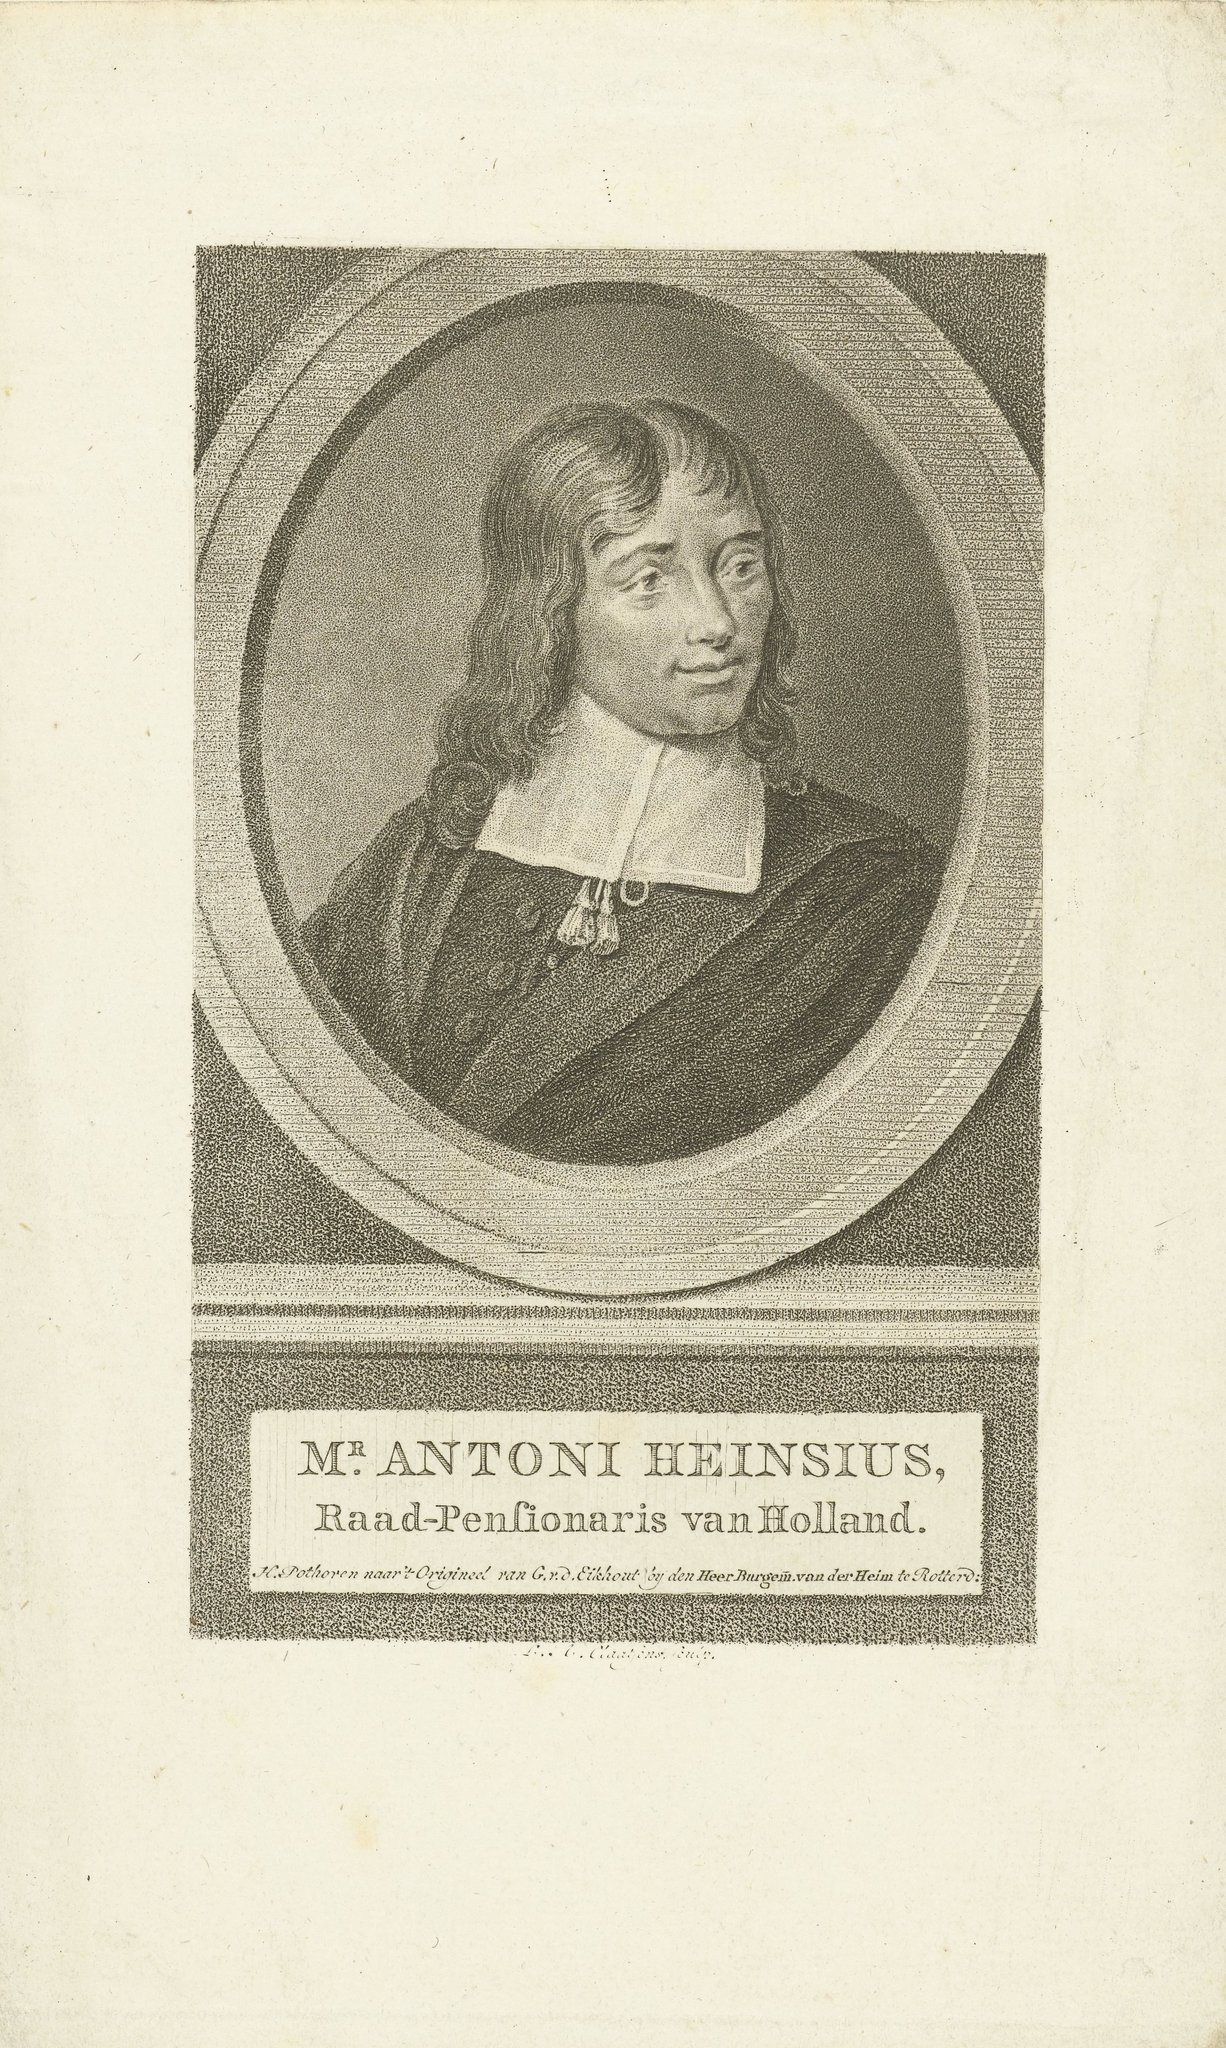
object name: print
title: Portret van Antonius Heinsius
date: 1792-1808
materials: paper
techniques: engraving, etching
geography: amsterdam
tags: the hague, anthonie heinsius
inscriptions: collector's mark: Lugt 2228